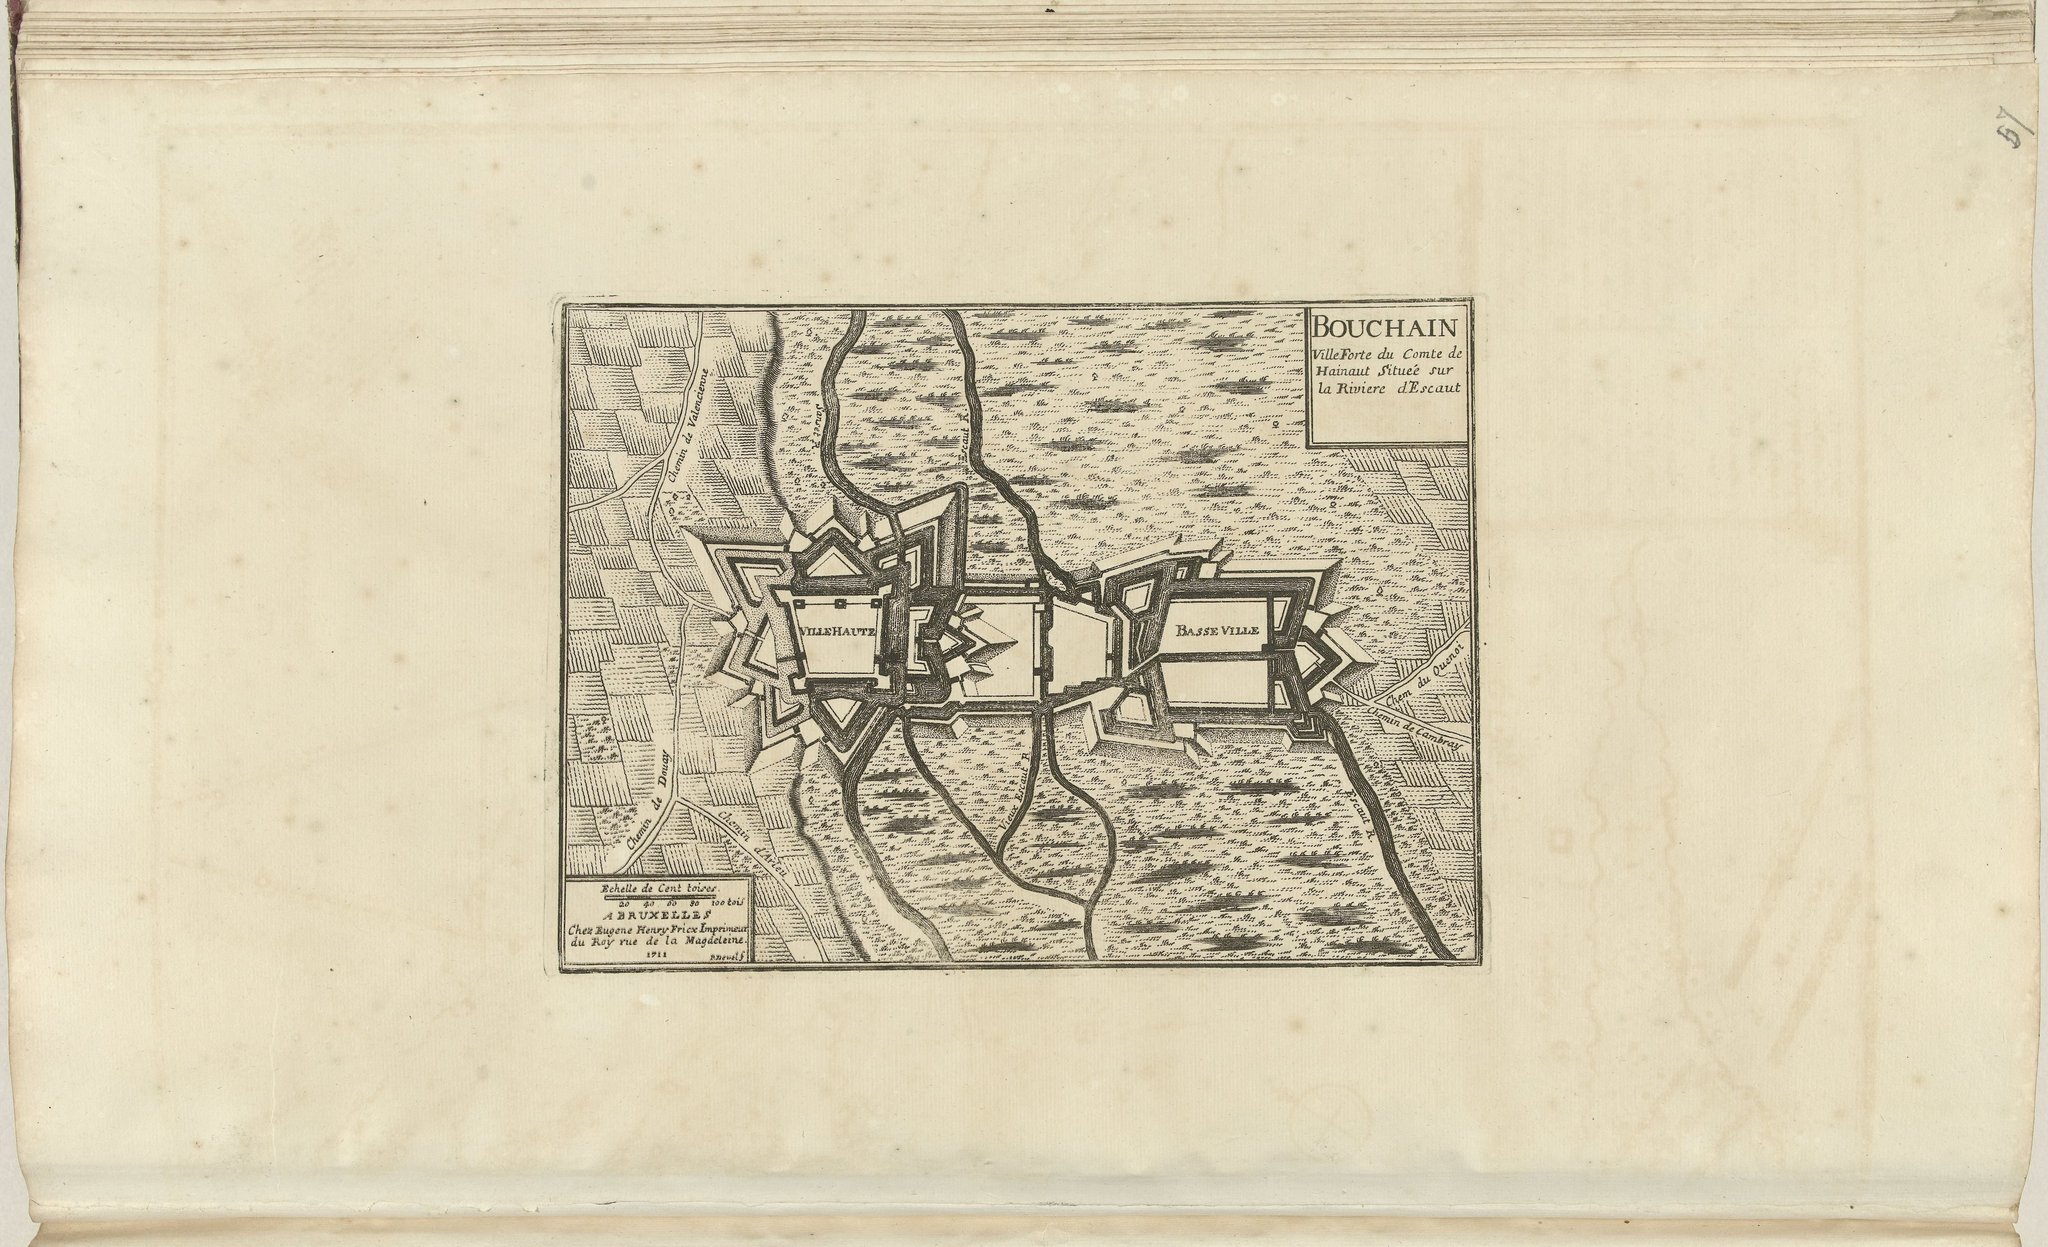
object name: print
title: Bouchain Ville Forte du Comte de Hainaut Située sur la Riviere d'Escaut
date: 1711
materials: paper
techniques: engraving, etching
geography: brussels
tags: maps of cities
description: Plattegrond van Bouchain, belegerd in 1711 door de Geallieerden. Onderdeel van een gebundelde verzameling van plannen van veldslagen en steden vermaard in de Spaanse Successieoorlog.